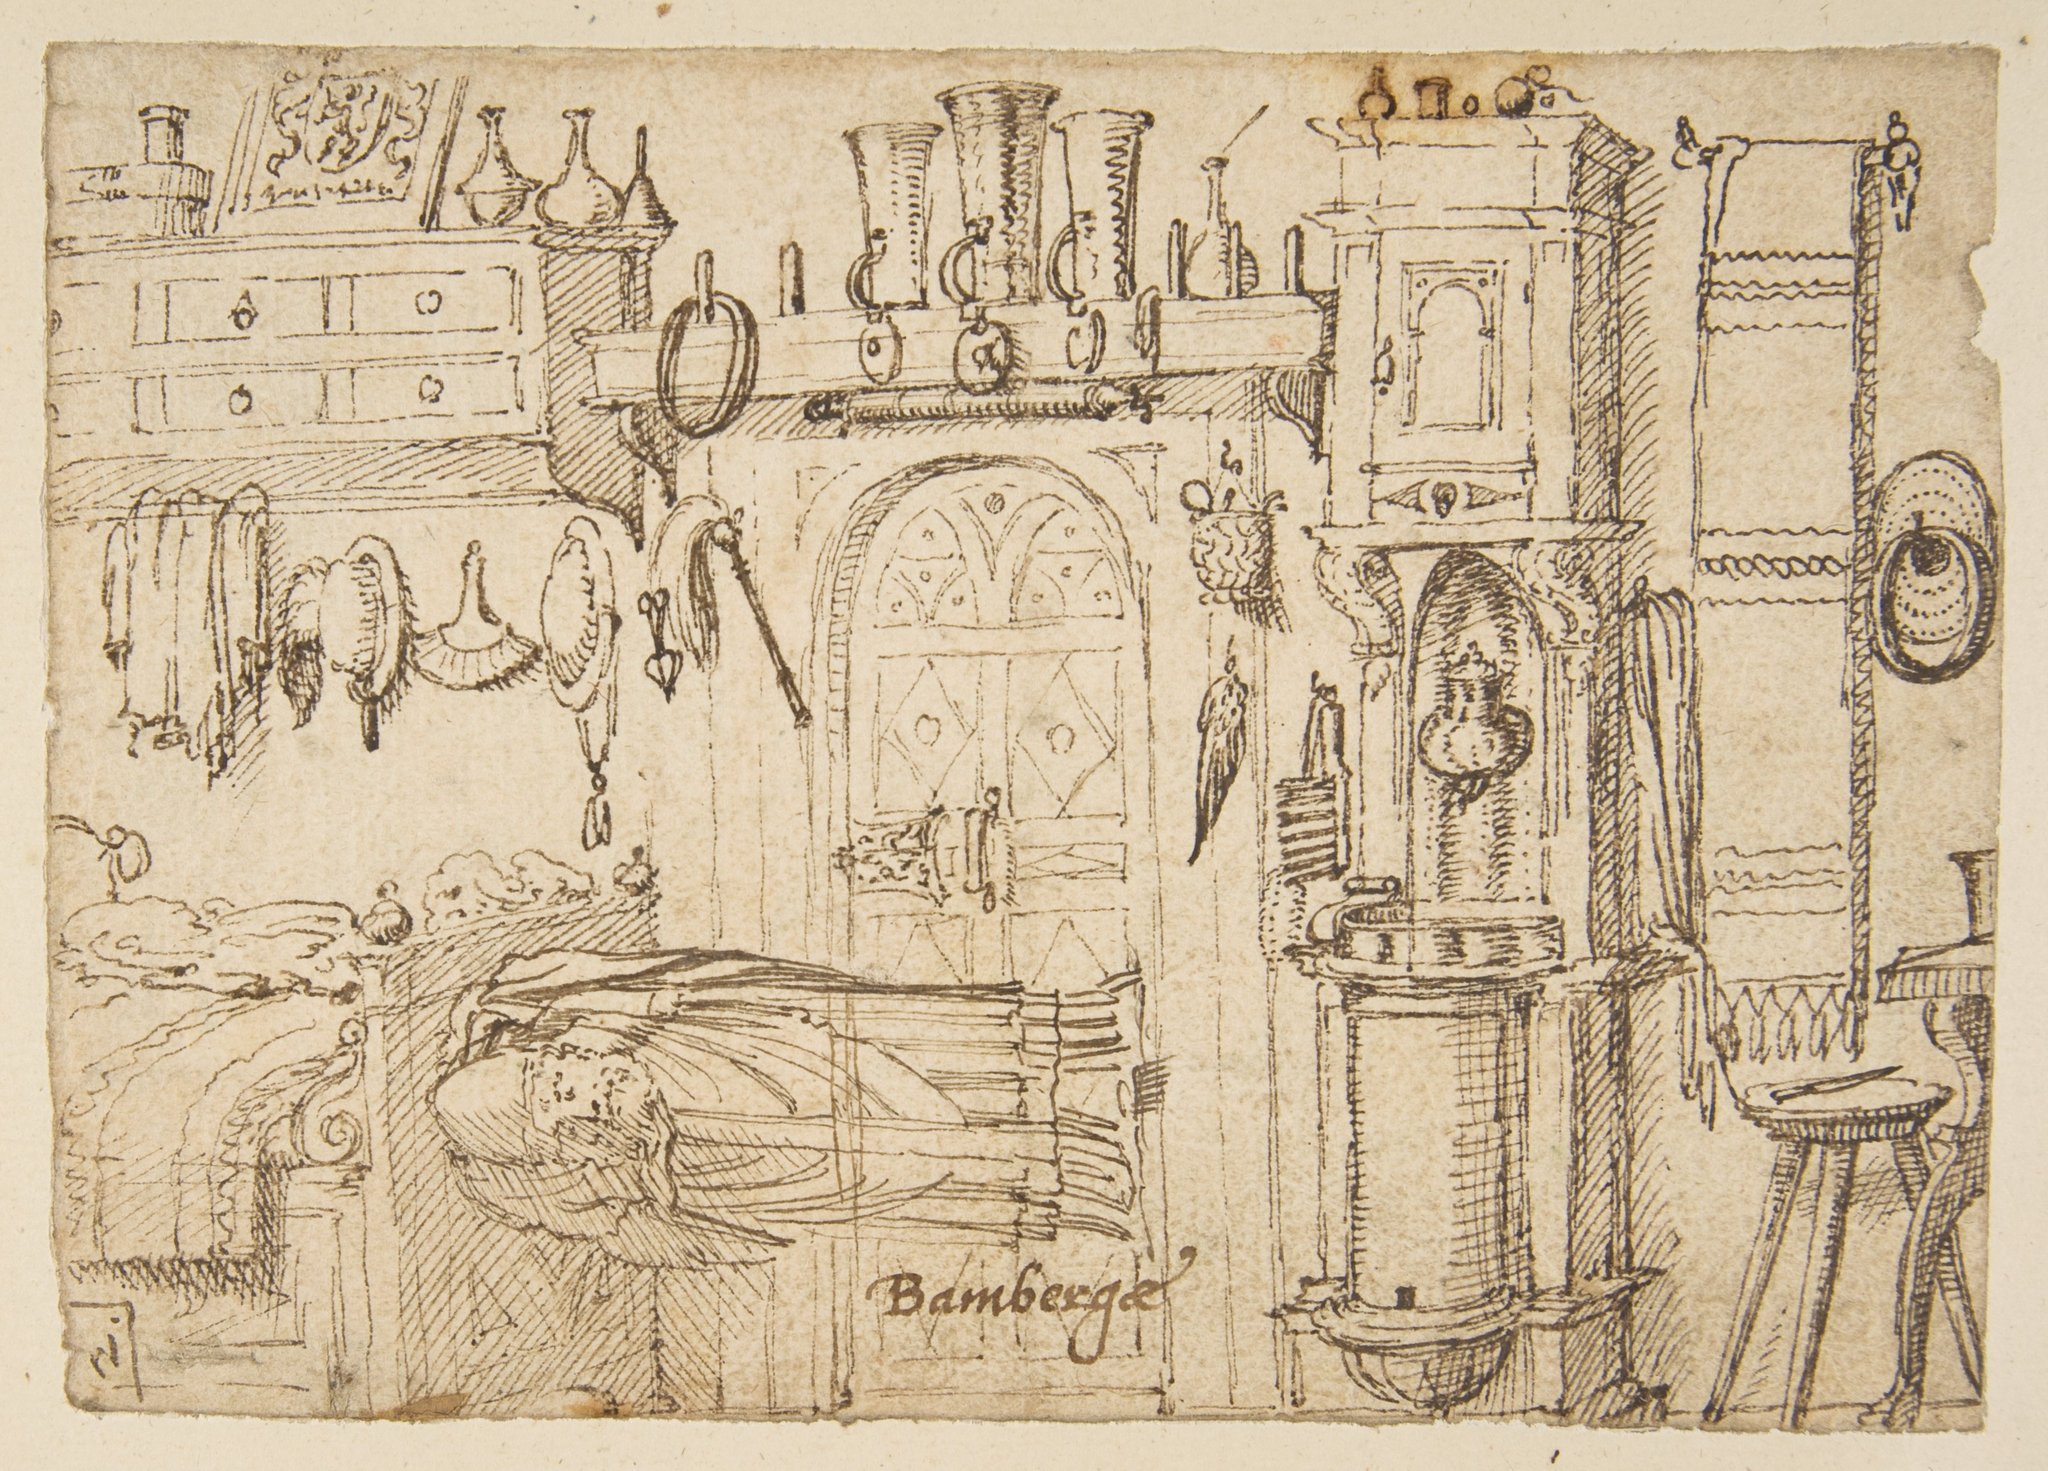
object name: drawing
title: Study sheets with sketches of interiors, animals, sculpture, figures, notes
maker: anonymous, german, 16th century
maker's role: artist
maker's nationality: german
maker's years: 1500-1600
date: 1501-1600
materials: ink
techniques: pen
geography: germany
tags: interiors